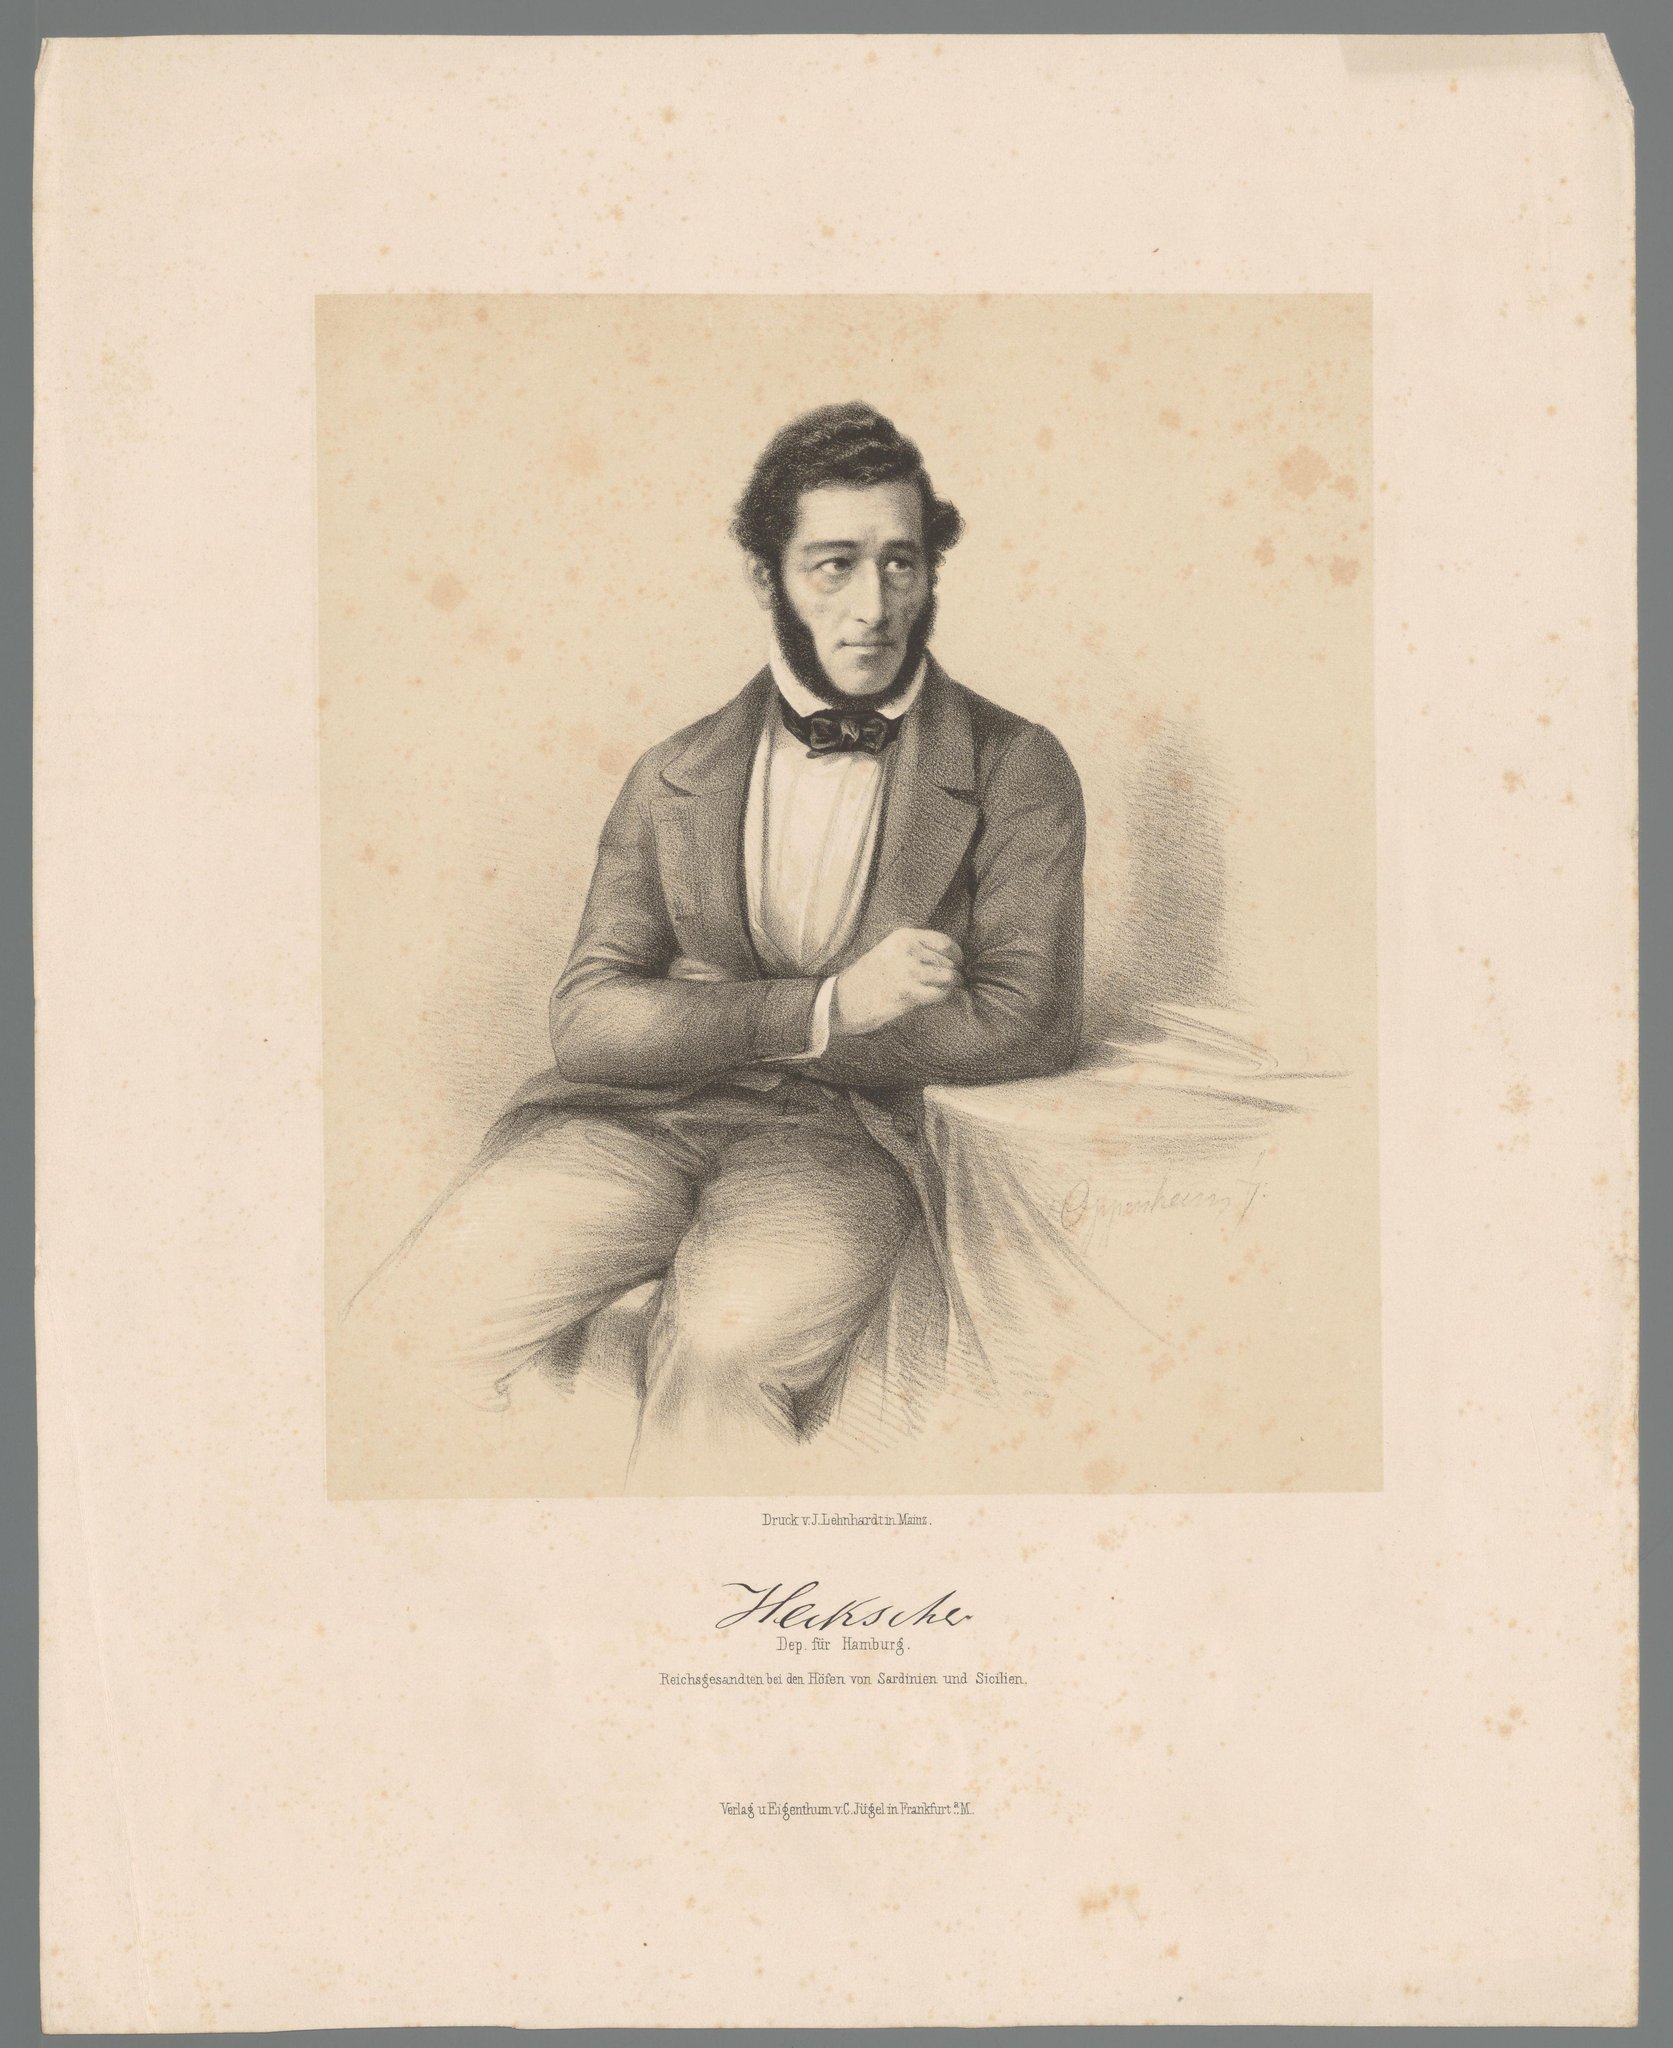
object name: print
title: Heckscher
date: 1848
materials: paper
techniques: tone lithography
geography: frankfurt am main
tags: adult man, historical persons, table